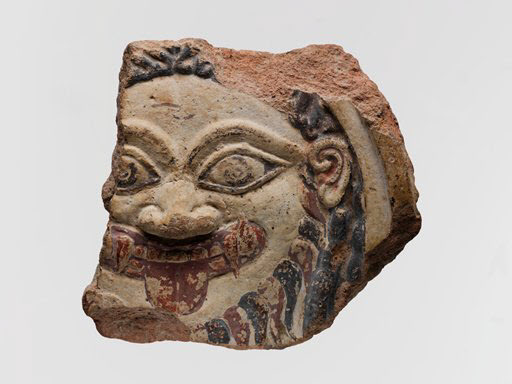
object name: antefix, head of medusa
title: Terracotta antefix with the head of Medusa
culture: etruscan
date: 600-501 BCE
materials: paint, terracotta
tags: heads,medusa